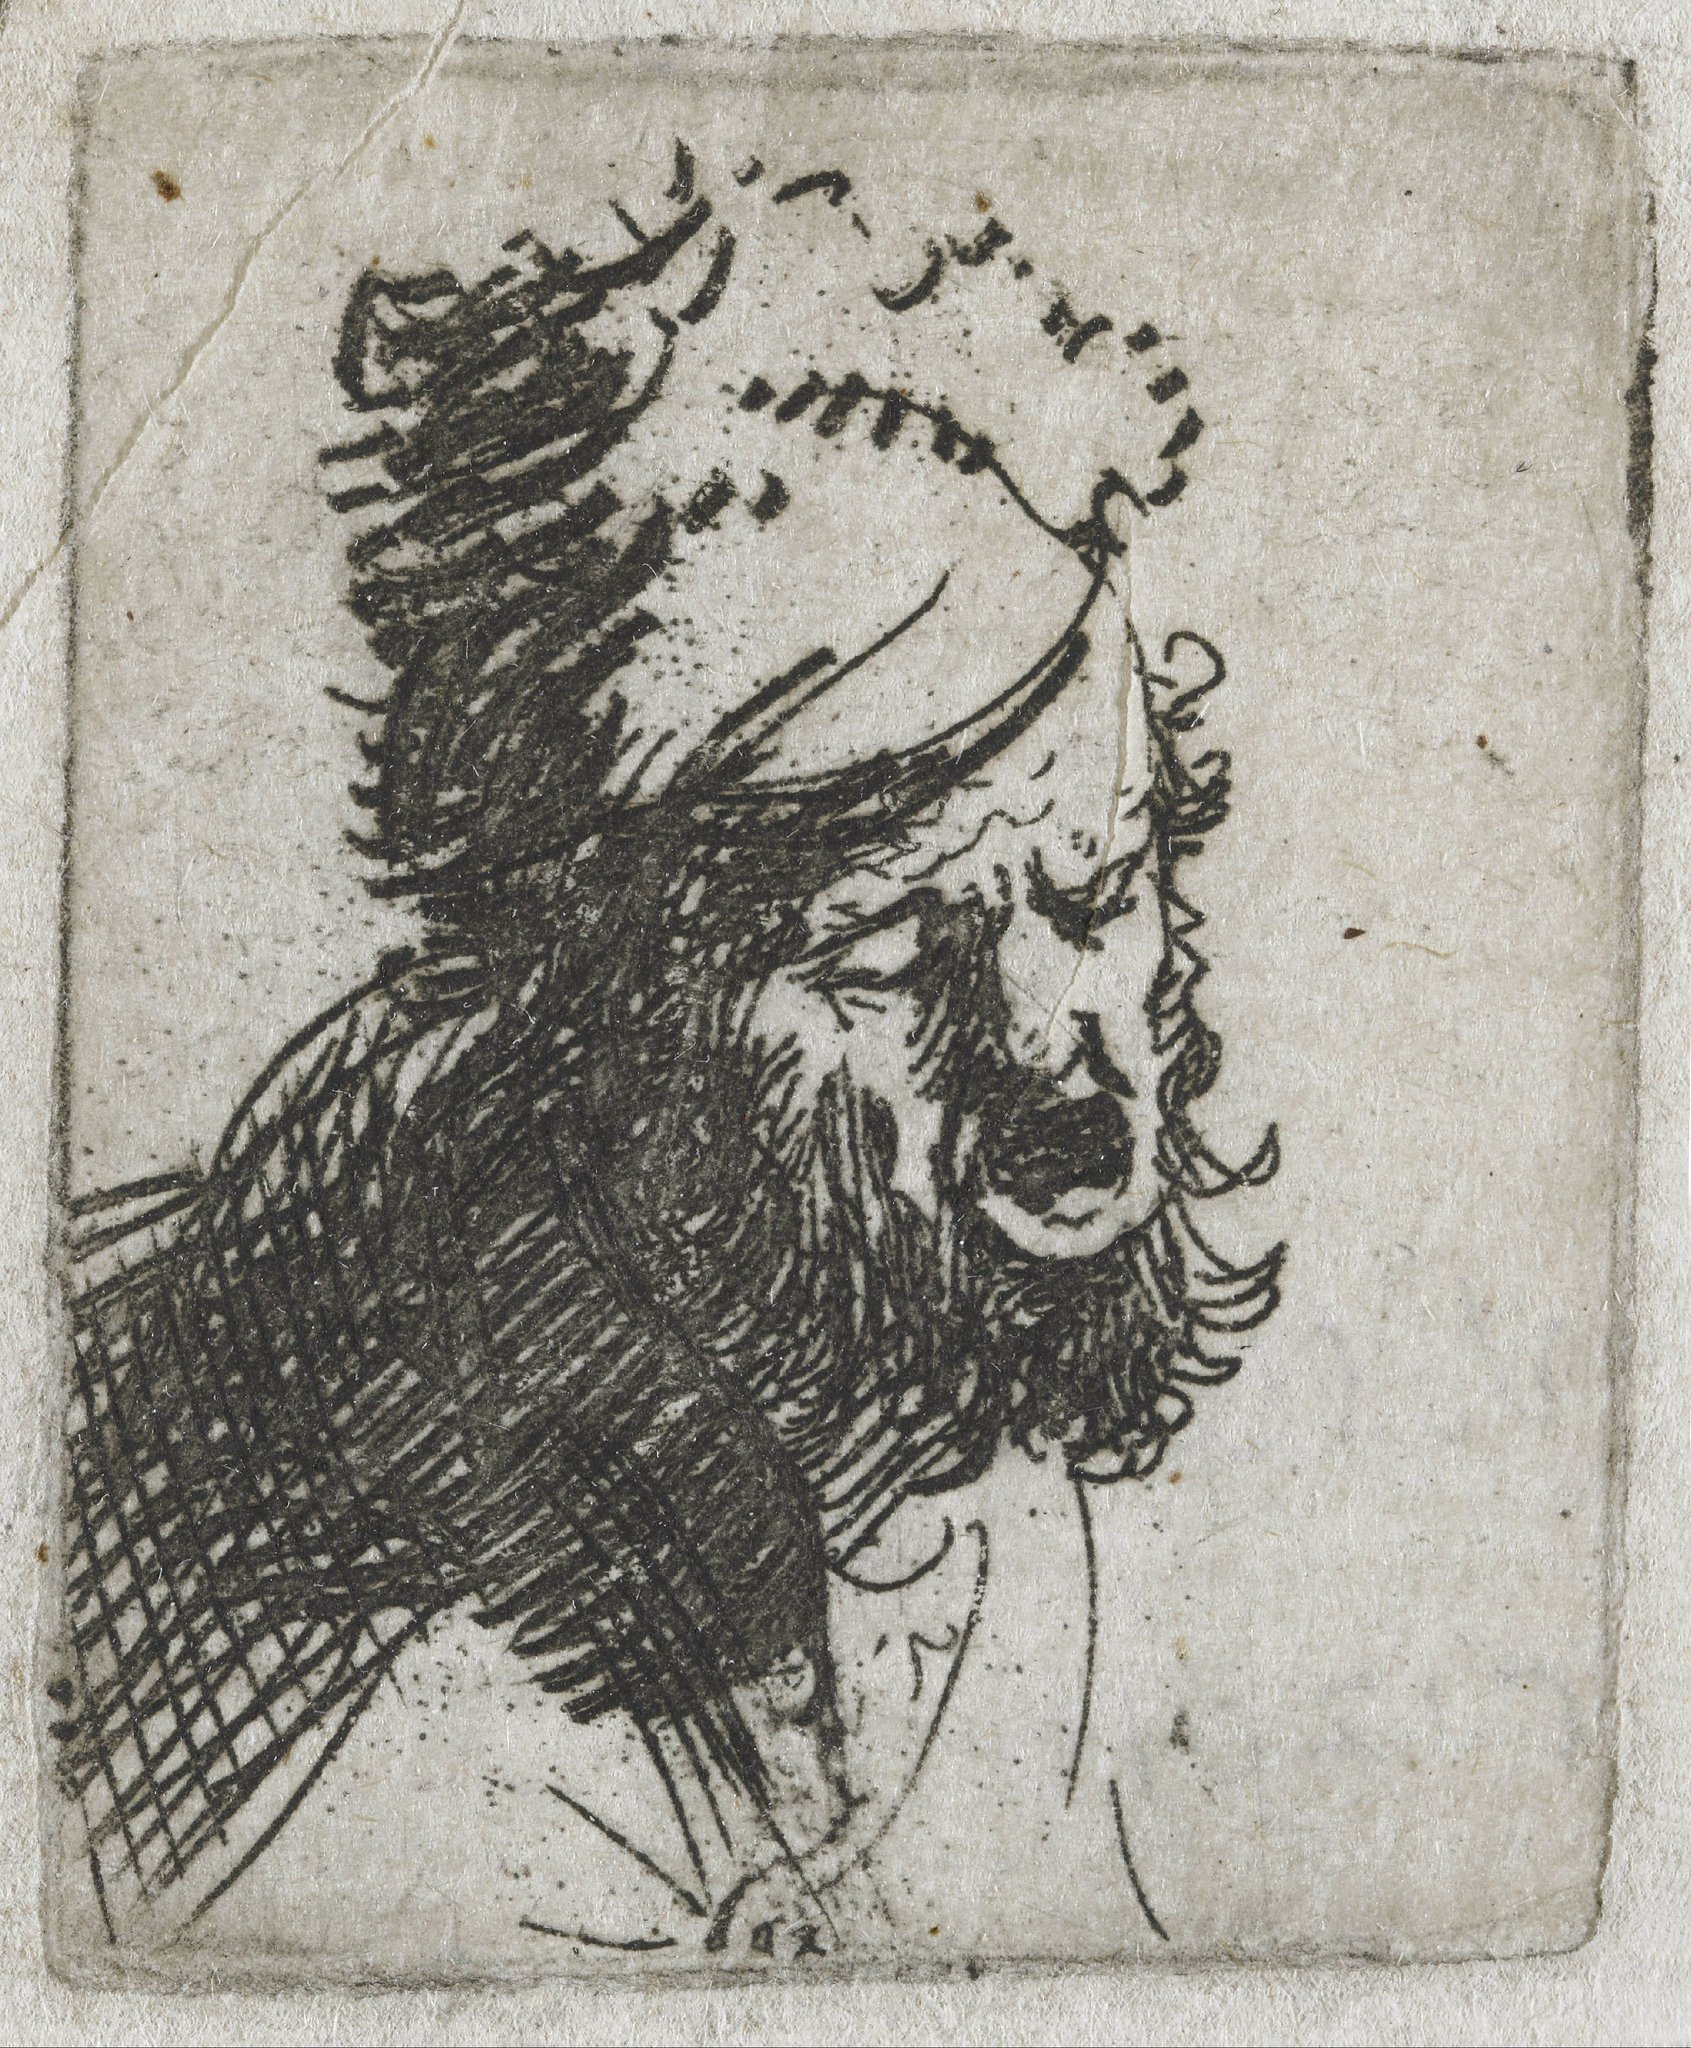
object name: print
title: Head of a man in a fur cap, crying out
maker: rembrandt van rijn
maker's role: draughtsman, painter, print maker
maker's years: 1606-1669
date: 1629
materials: paper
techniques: etching, intaglio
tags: head-gear (with name)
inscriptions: inscription: ‘Valletti / 1807’ Lugt 2478 a, inscription: ‘C. 12010’